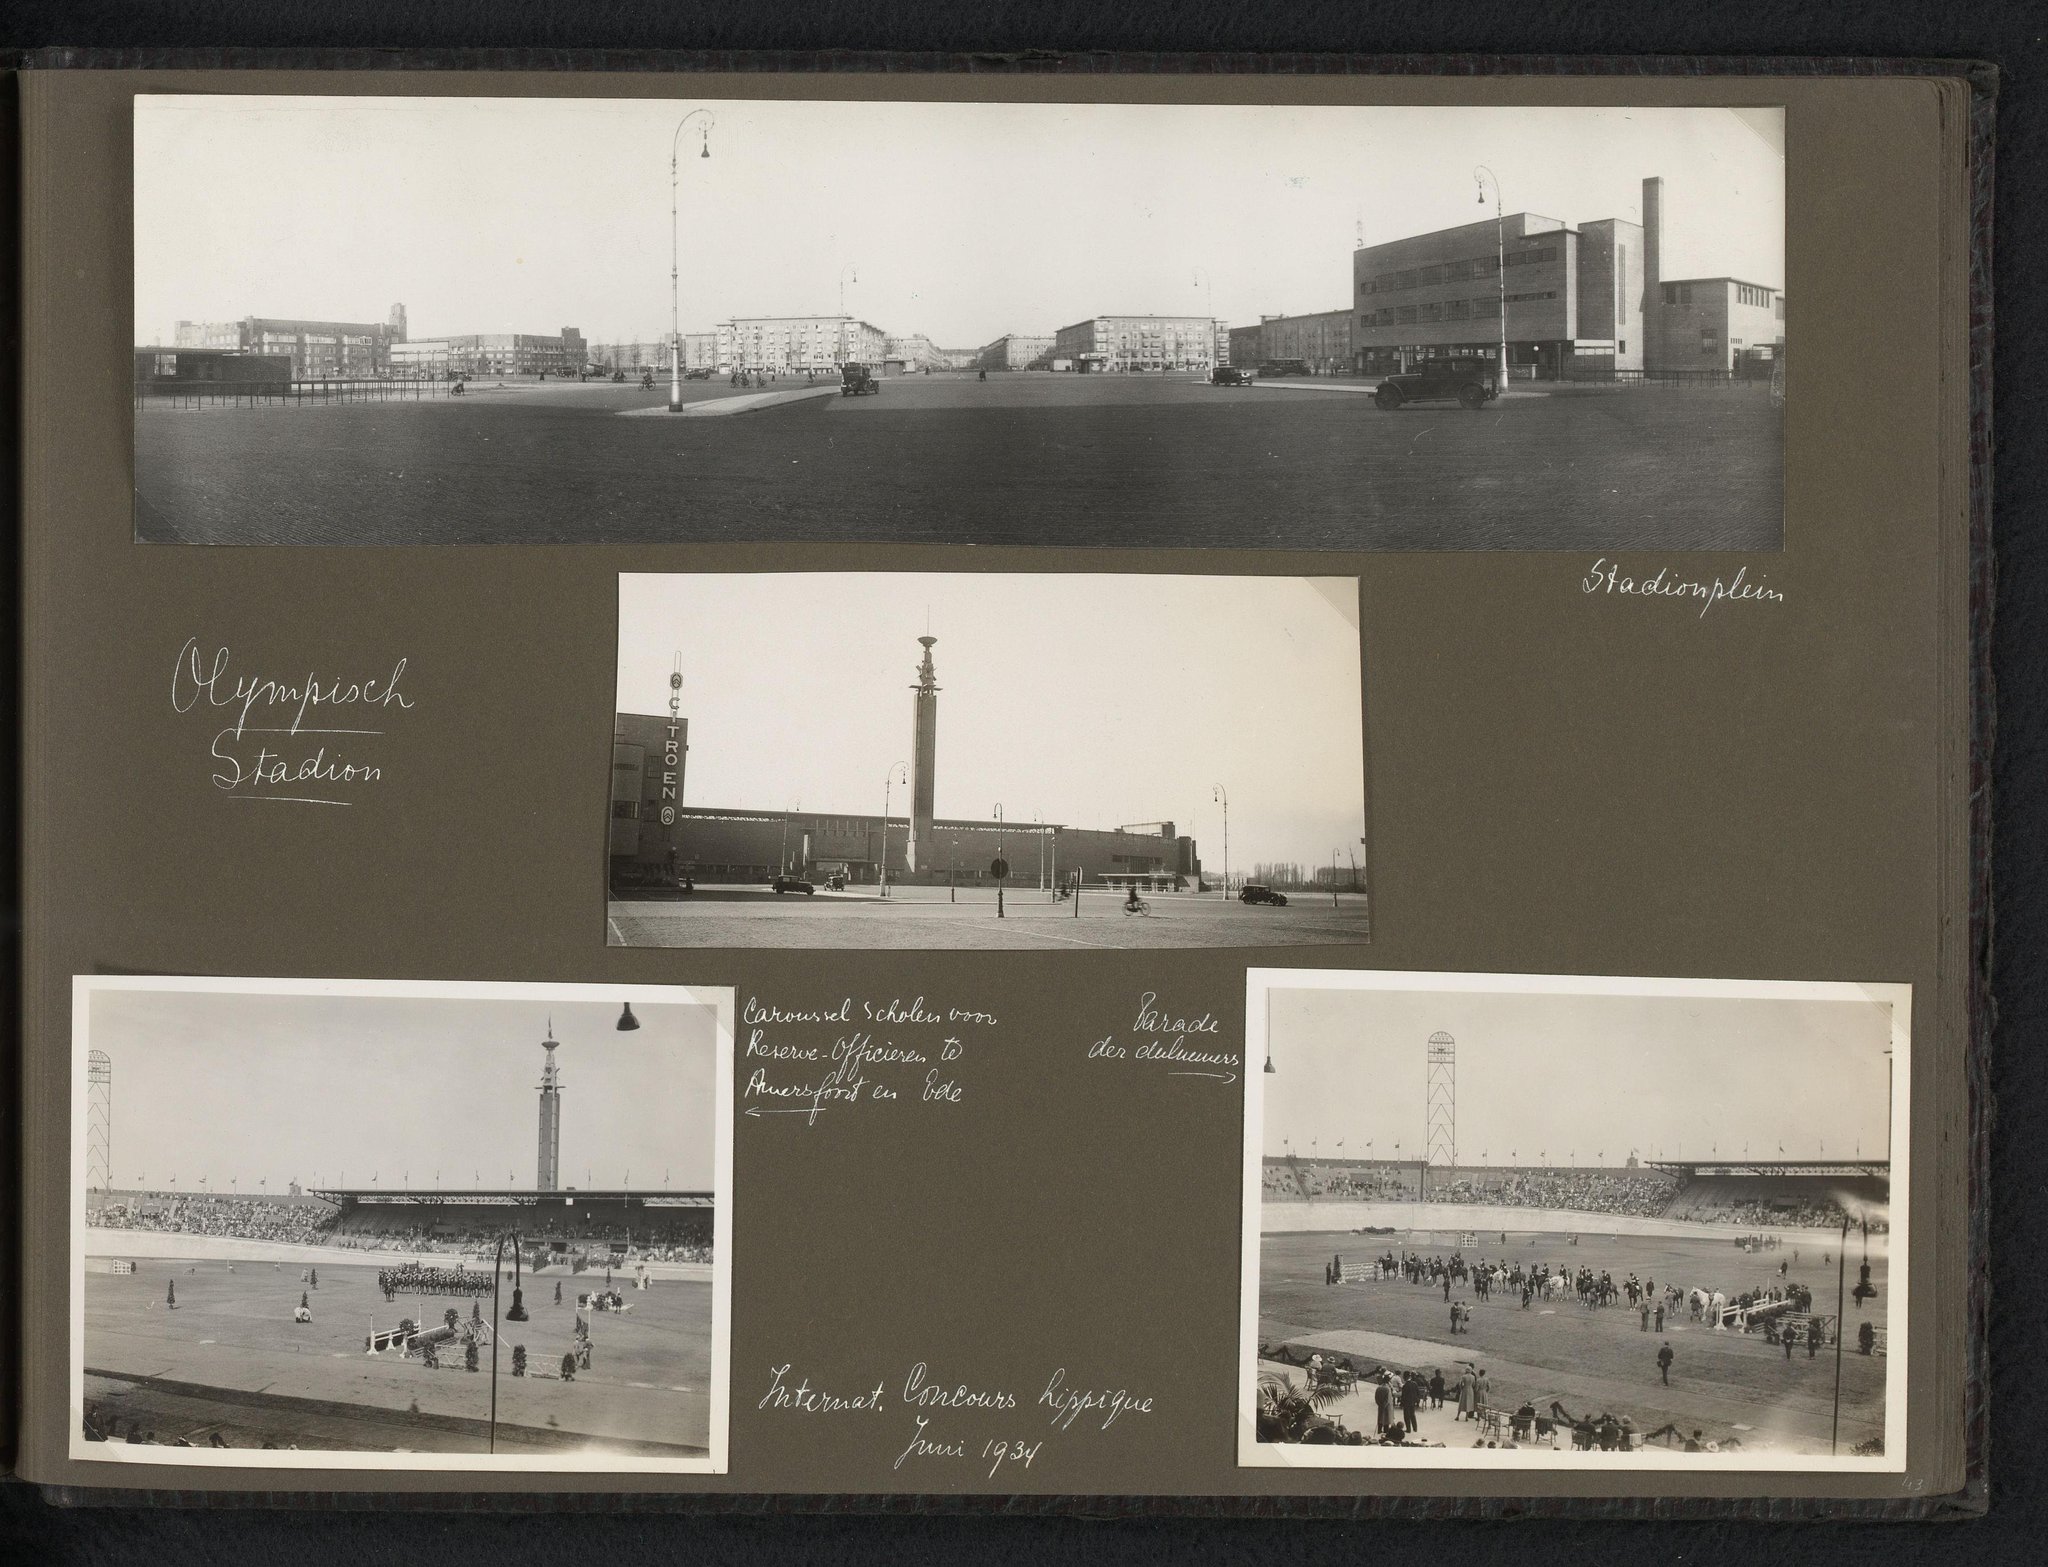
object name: photograph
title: Olympisch Stadion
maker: frank willem van den berg (1912-1998)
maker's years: 1912-1998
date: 1906-1934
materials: paper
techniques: gelatin silver print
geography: amsterdam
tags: square, place, circus, etc., grounds, fields and accomodations for sports, games and physical performances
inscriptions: inscription: ‘Caroussel scholen voor/ Reserve-Officieren te/ Amersfoort en Ede’, inscription: ‘Internat. Concours hippique/ Juni 1934’, inscription: ‘Stadionplein’, inscription: ‘Parade/ der deelnemers’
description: Deze foto's maken deel uit van een album.